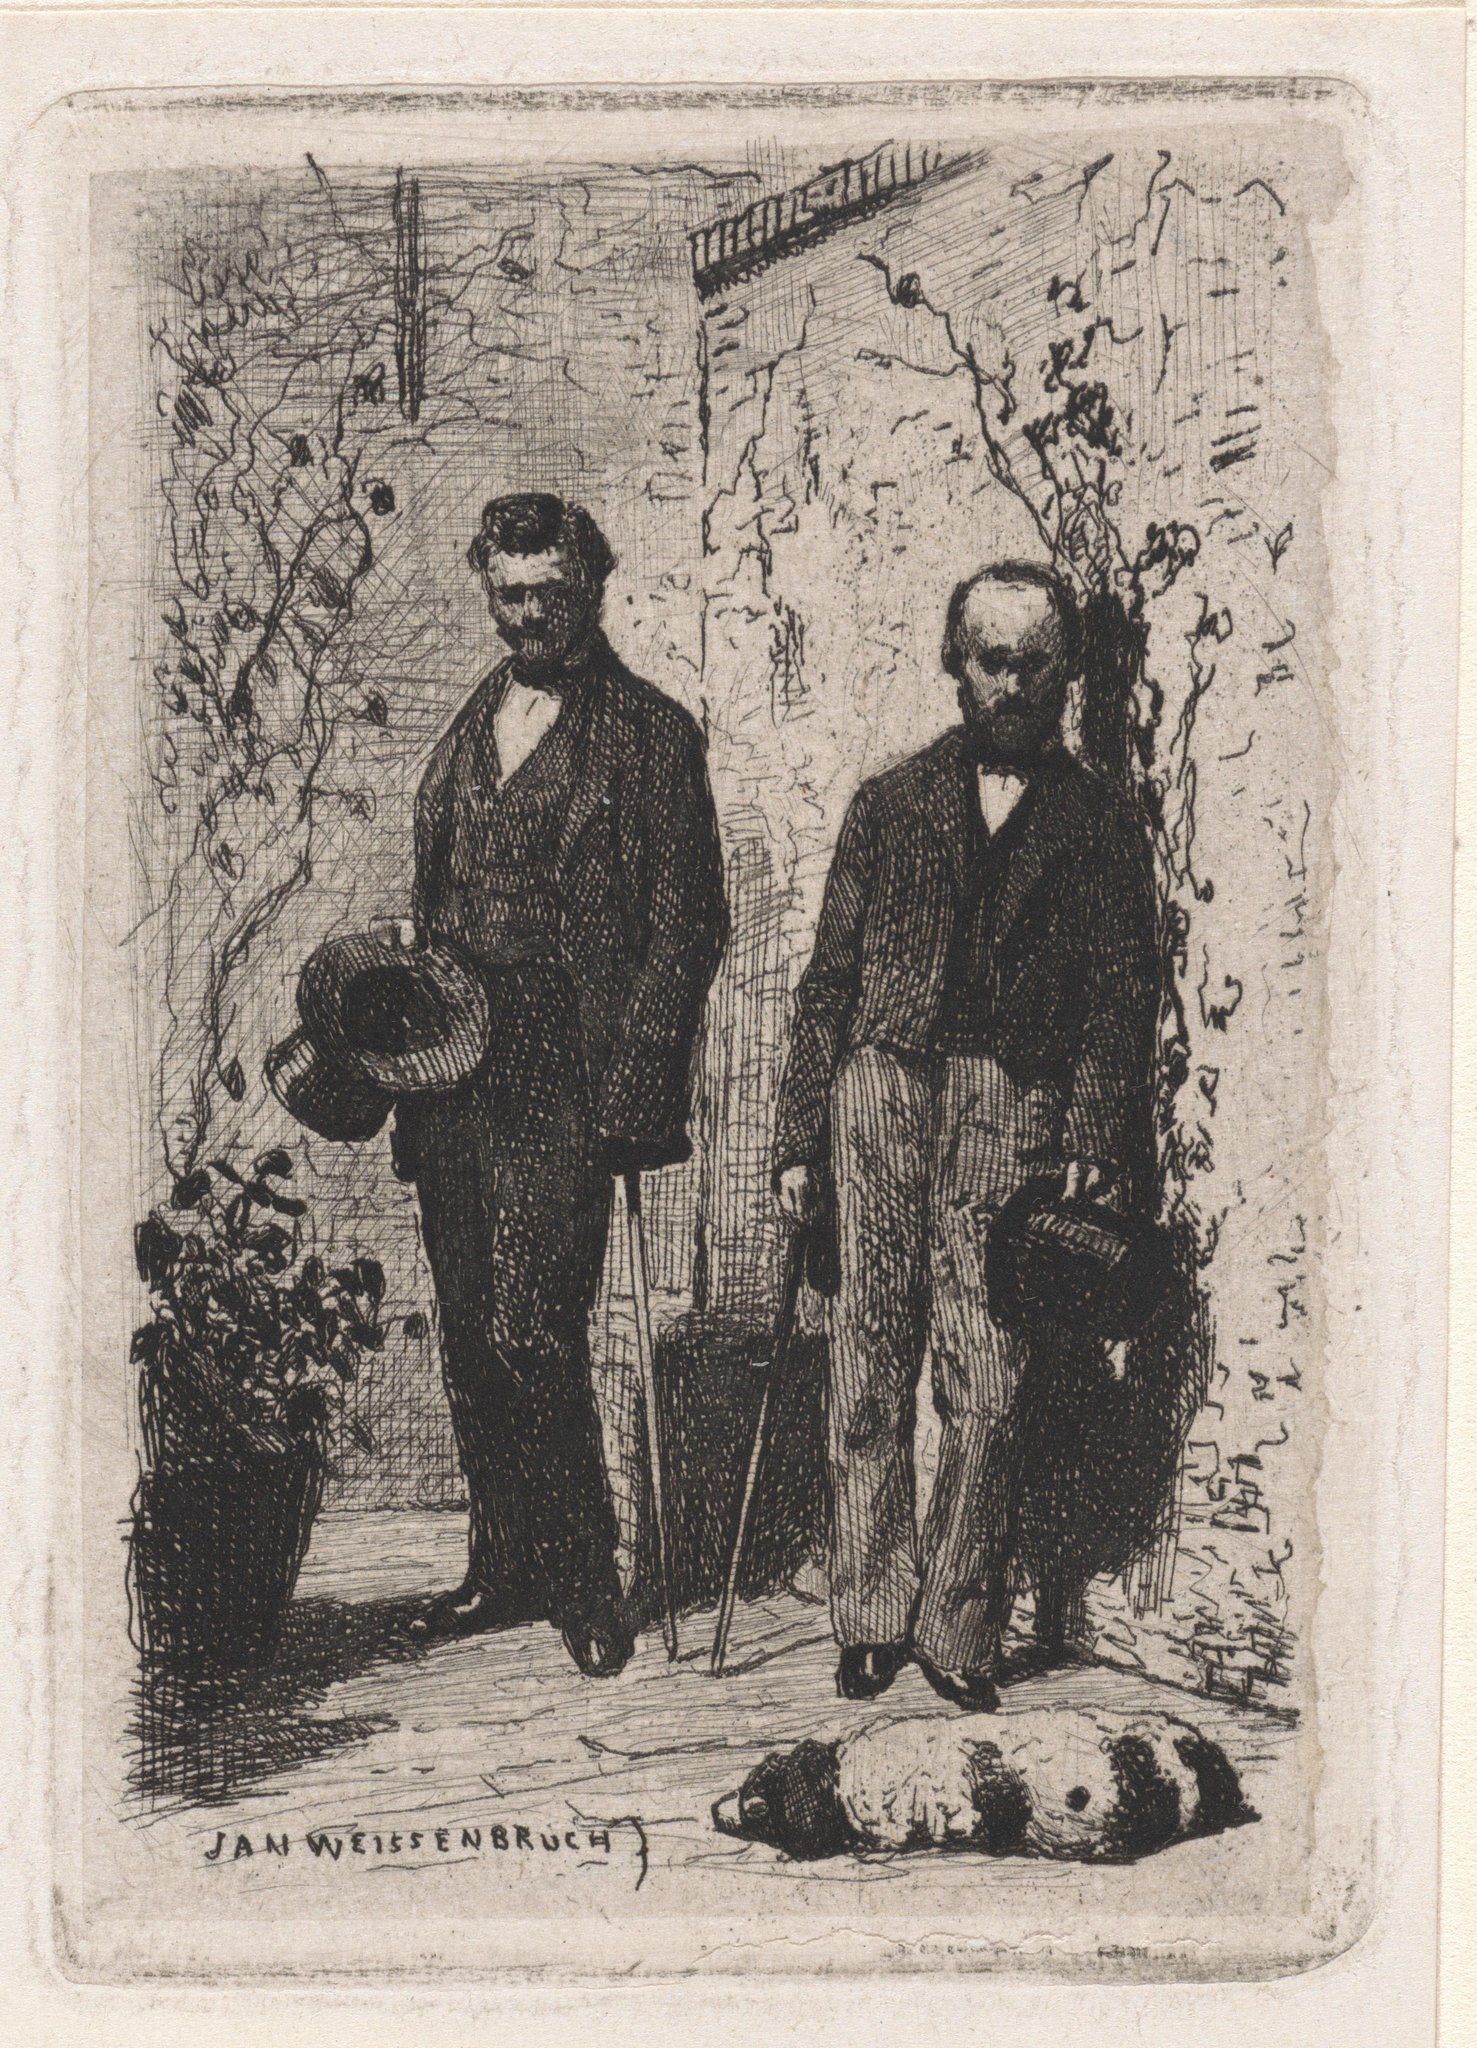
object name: print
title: Zelfportret met Frederik Hendrik Weissenbruch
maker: jan weissenbruch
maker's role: painter, print maker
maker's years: 1822-1880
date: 1837-1880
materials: paper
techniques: etching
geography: the hague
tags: the hague, painter, print maker, jan weissenbruch, draughtsman, frederik hendrik weissenbruch, plants; vegetation, adult man, portrait, self-portrait of artist, dog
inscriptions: collector's mark: Lugt 2228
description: De kunstenaar Frederik Hendrik Weissenbruch (l) en zijn broer Jan Weissenbruch (r) staan bij een muur. Ze houden allebei een stok en een hoge hoed vast. Voor hen ligt een hond te slapen.